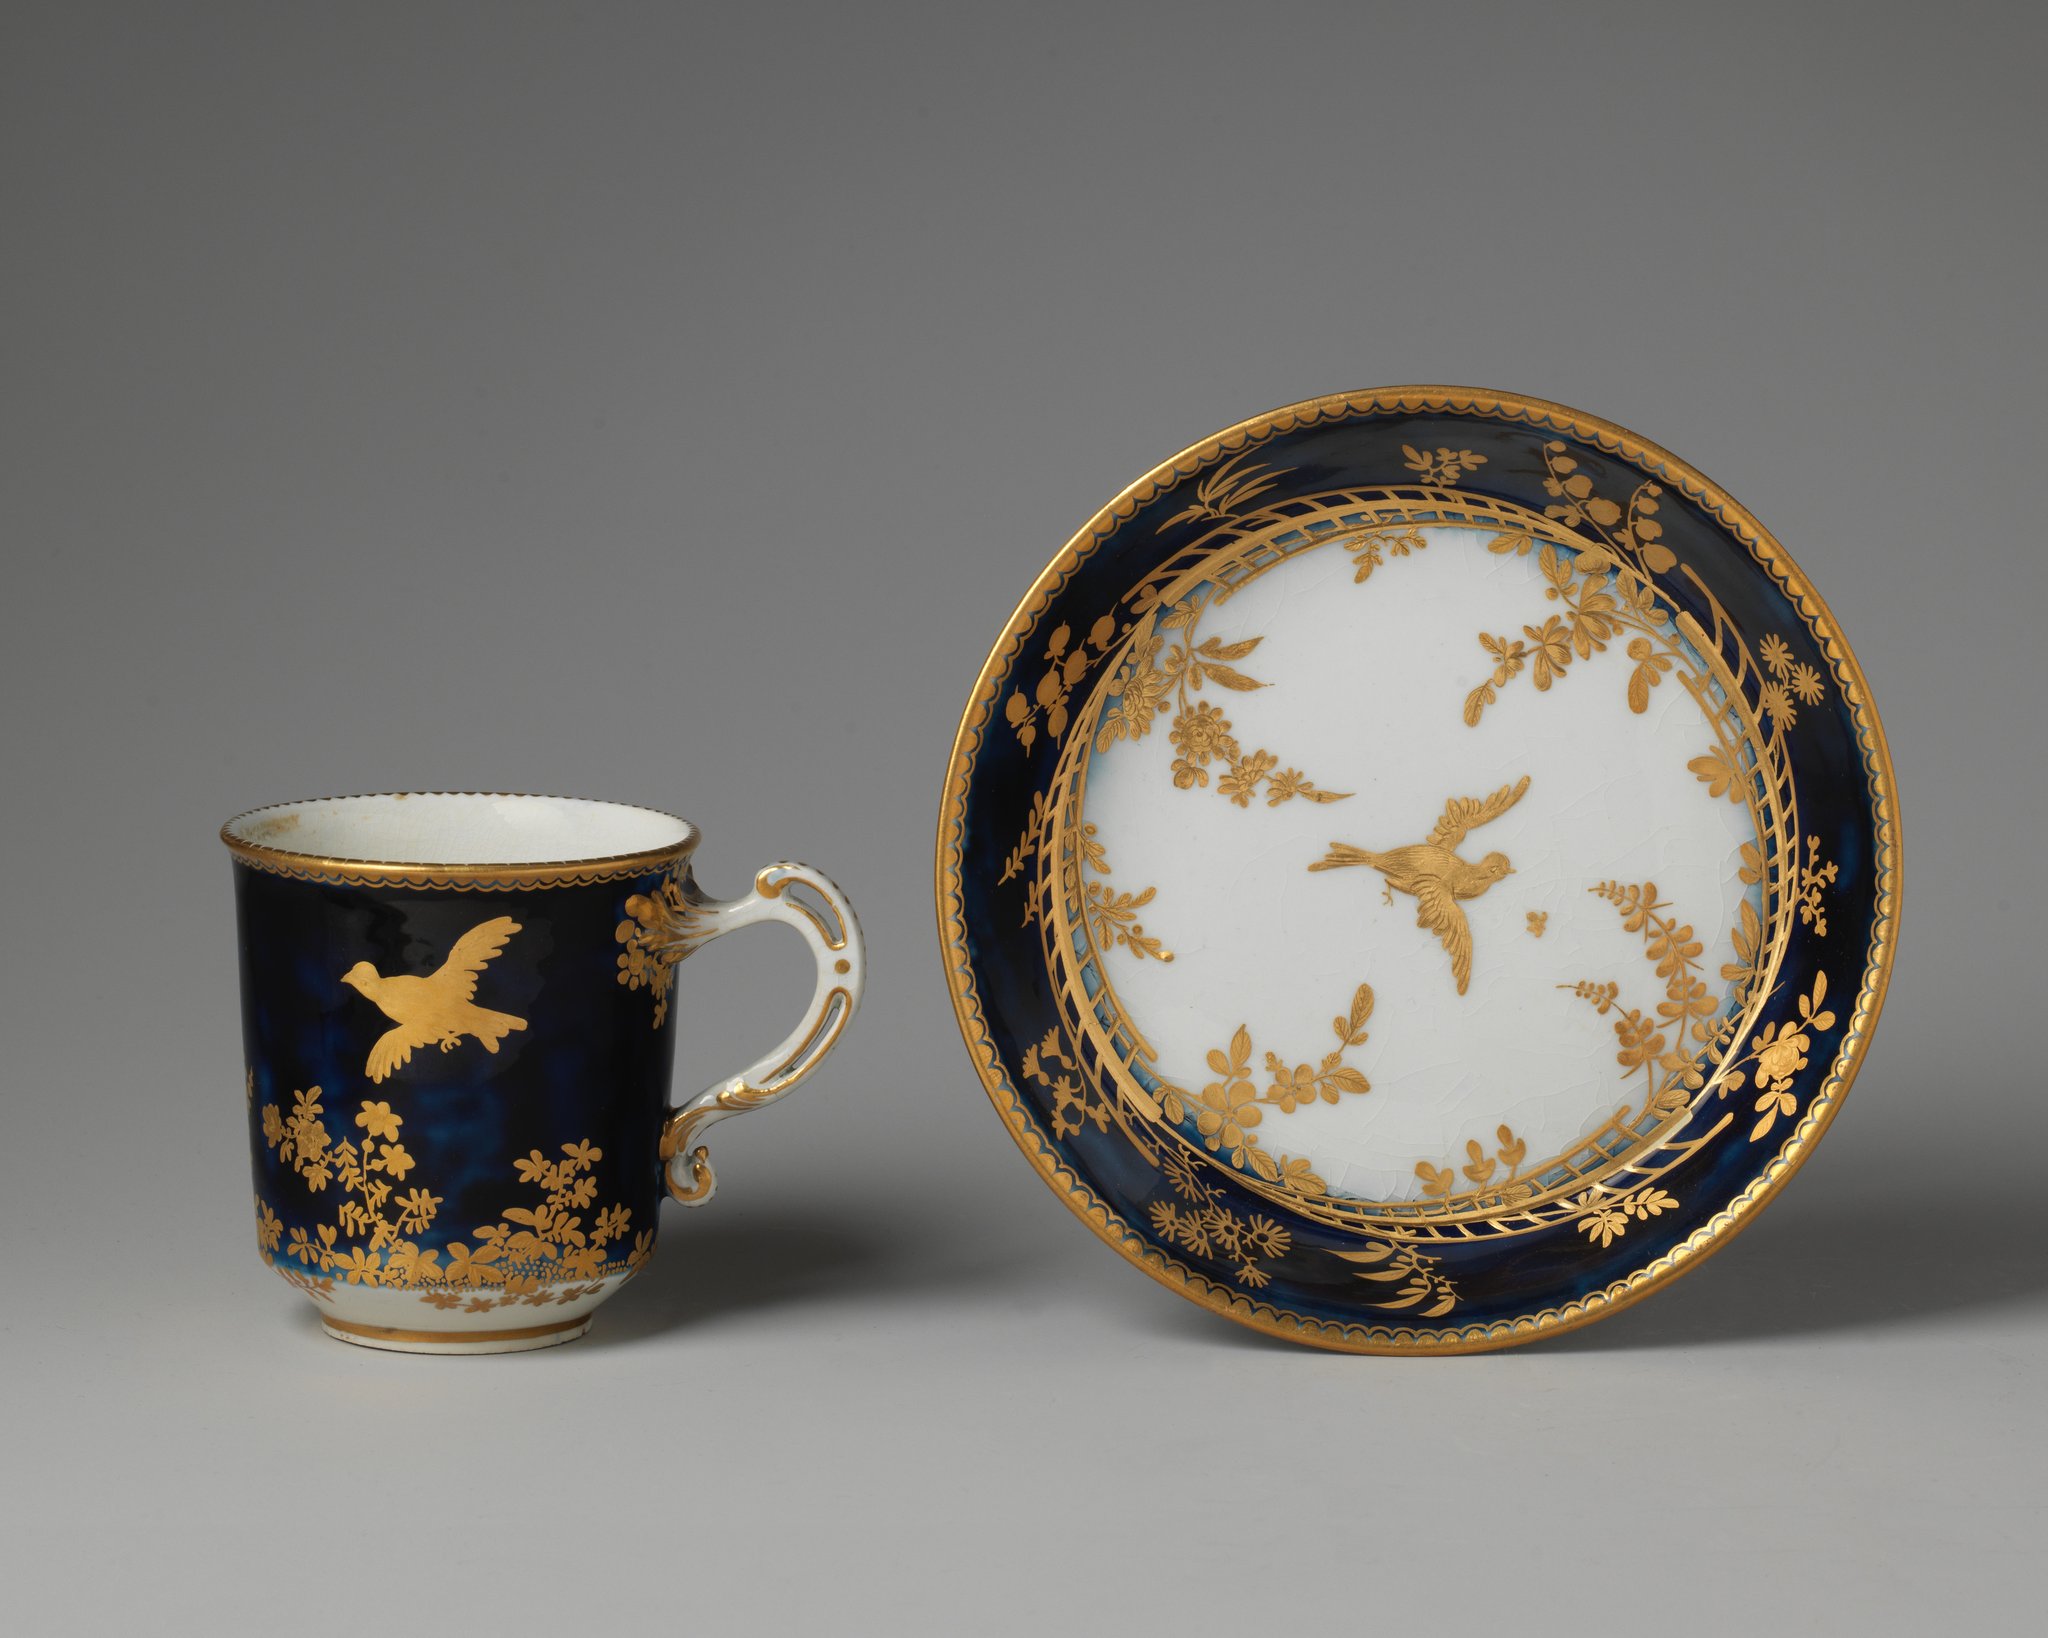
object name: cup and saucer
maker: chelsea porcelain manufactory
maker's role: factory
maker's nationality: british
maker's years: 1744-1784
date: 1765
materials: soft paste porcelain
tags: birds,flowers